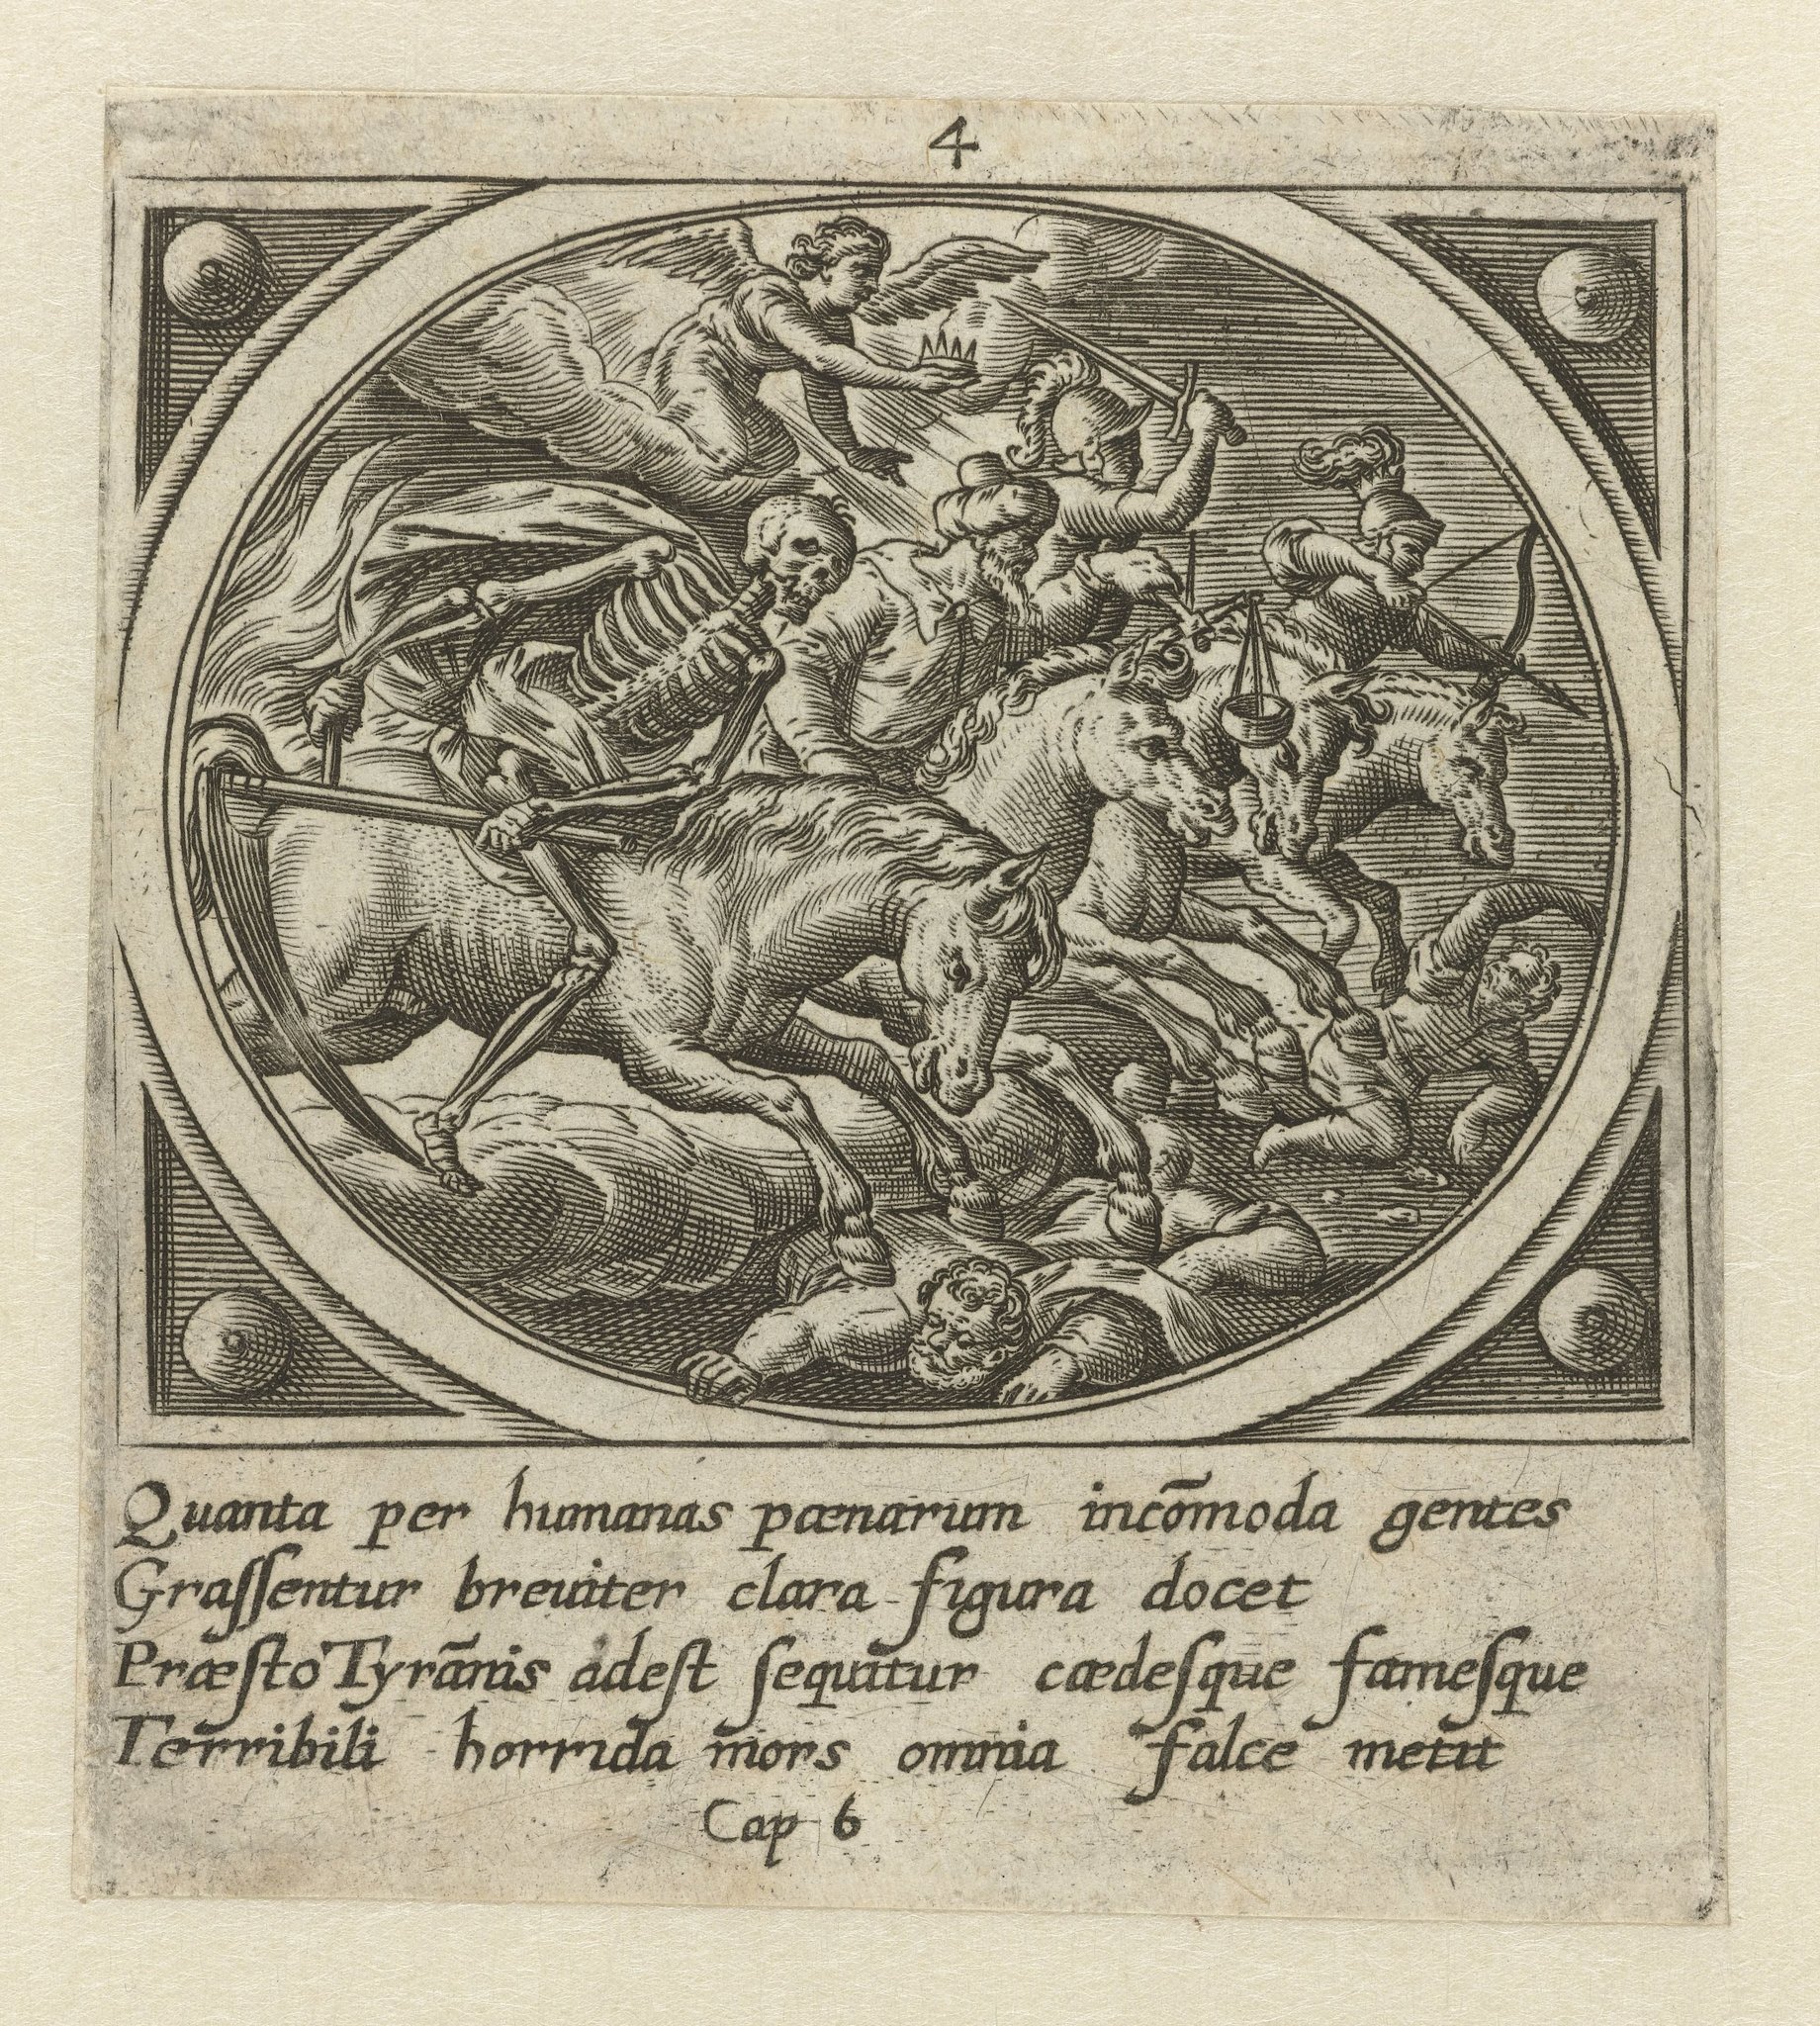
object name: print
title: Openbaring van Johannes op Patmos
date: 1585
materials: paper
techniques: engraving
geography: antwerp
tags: the four horsemen of the apocalypse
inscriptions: collector's mark: Lugt 2228, collector's mark: Lugt 2760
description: Het openen van de eerste vier zegels: de vier apocalyptische ruiters, 'Victorie', 'Oorlog', 'Honger' en 'Dood' vertrappen de mensheid. Boven hen een engel, met een kroon. In de marge een vierregelig onderschrift in het Latijn. Vierde prent uit een serie van vierentwintig met de openbaring van Johannes op Patmos.